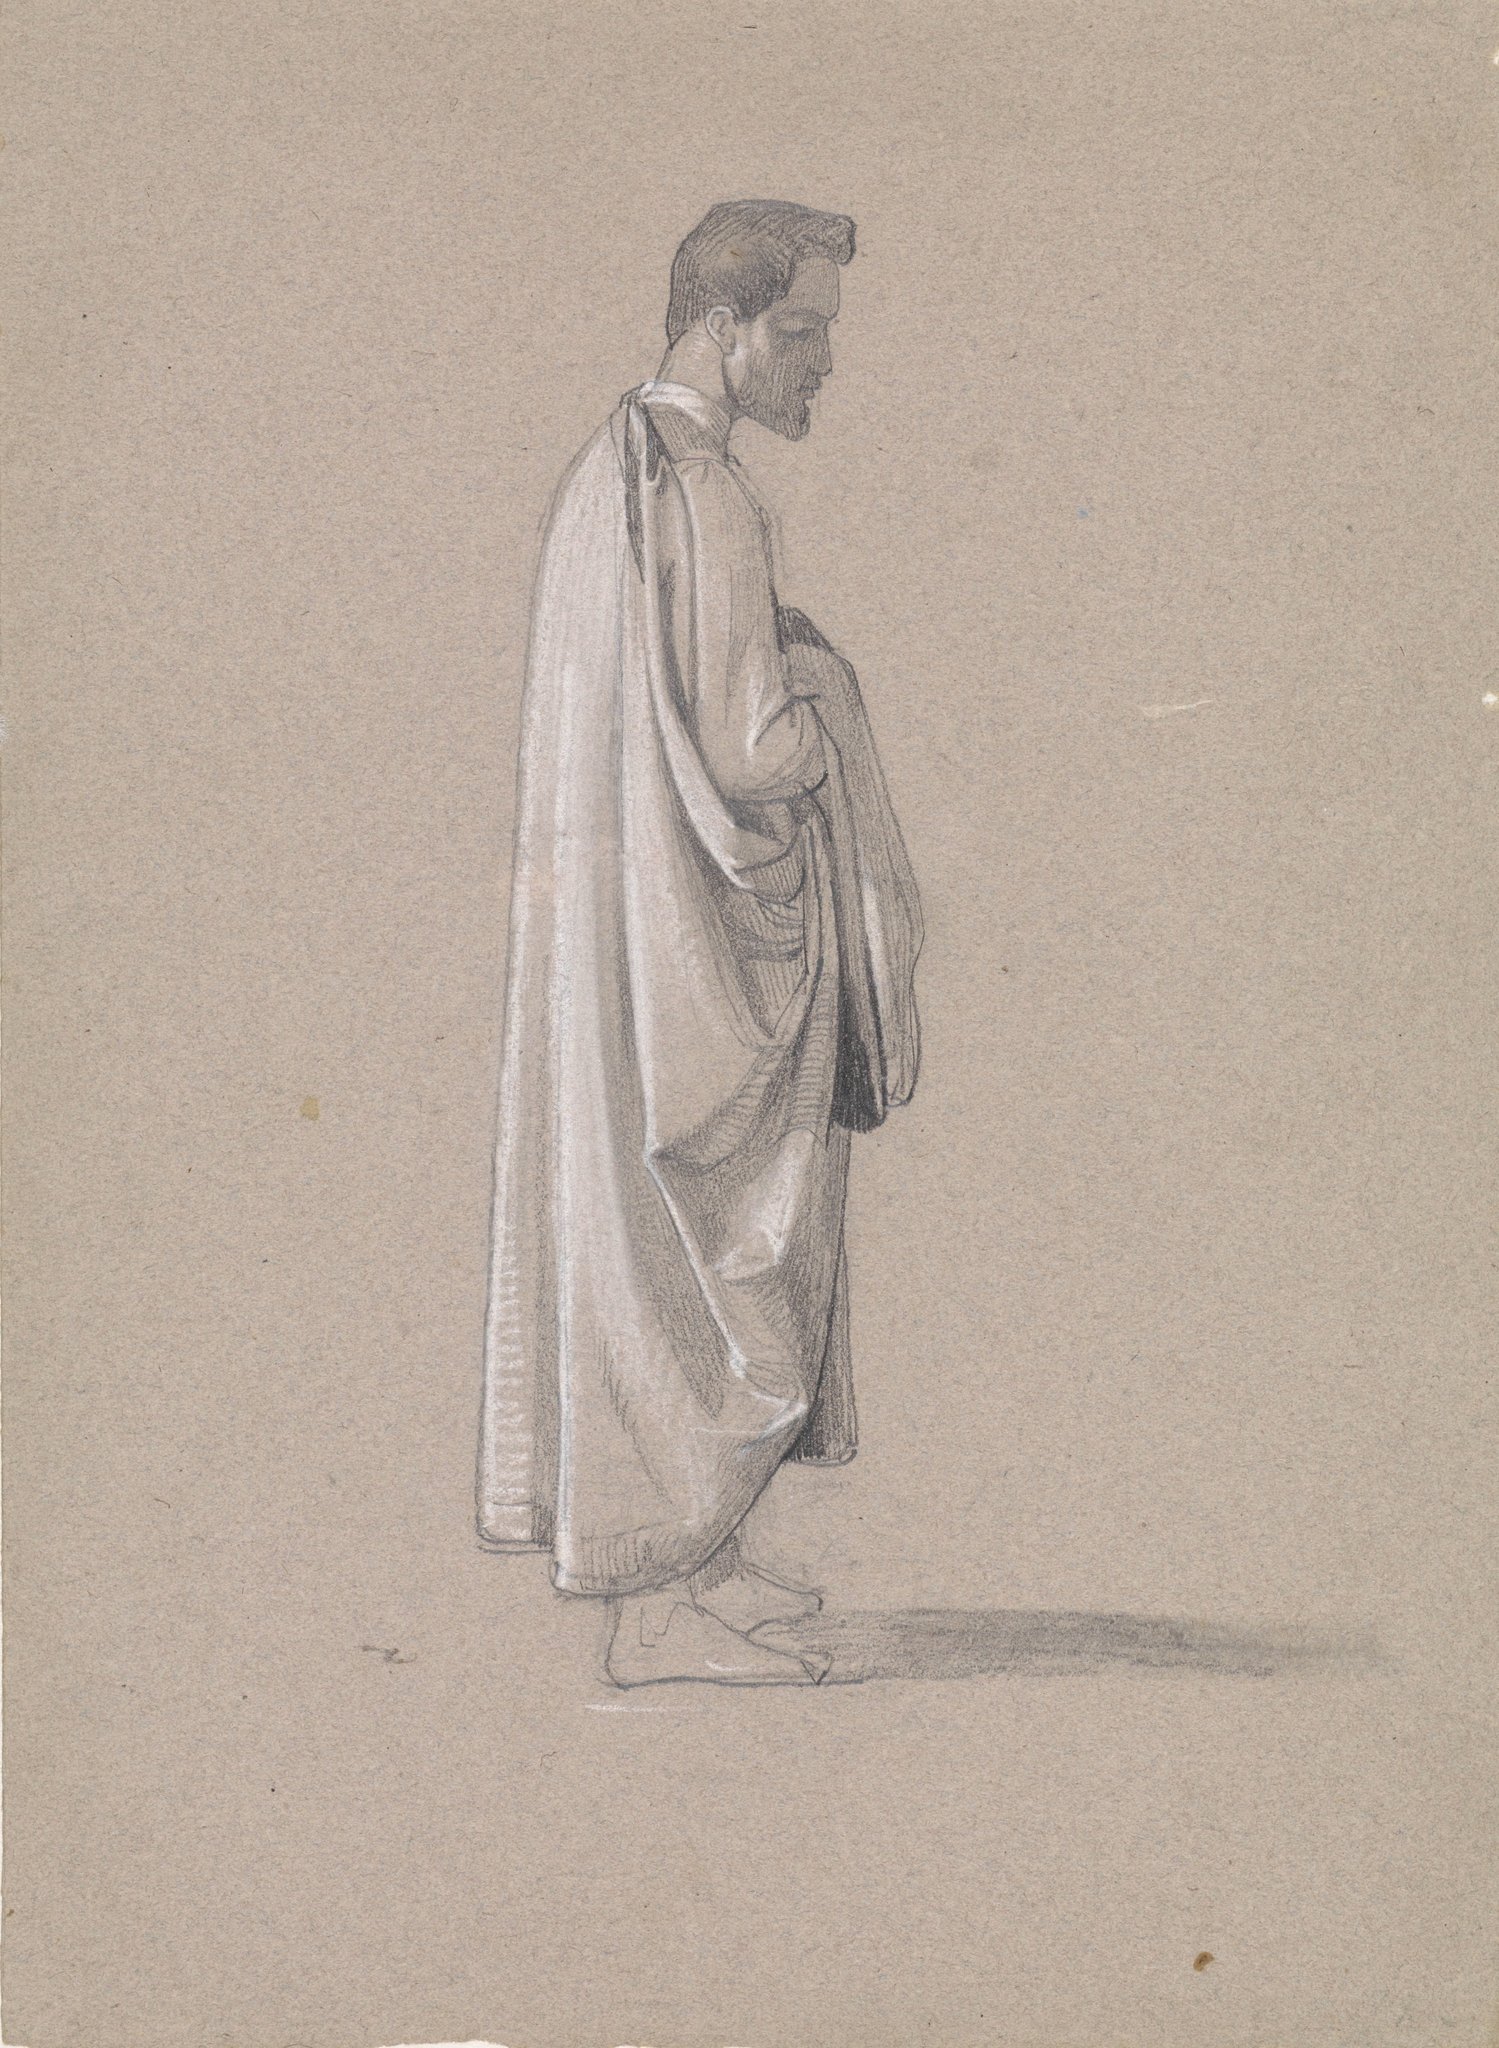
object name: drawing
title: Staande man in mantel, naar rechts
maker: johan hendrik koelman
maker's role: draughtsman, print maker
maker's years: 1820-1887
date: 1830-1887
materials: chalk, paper, pencil